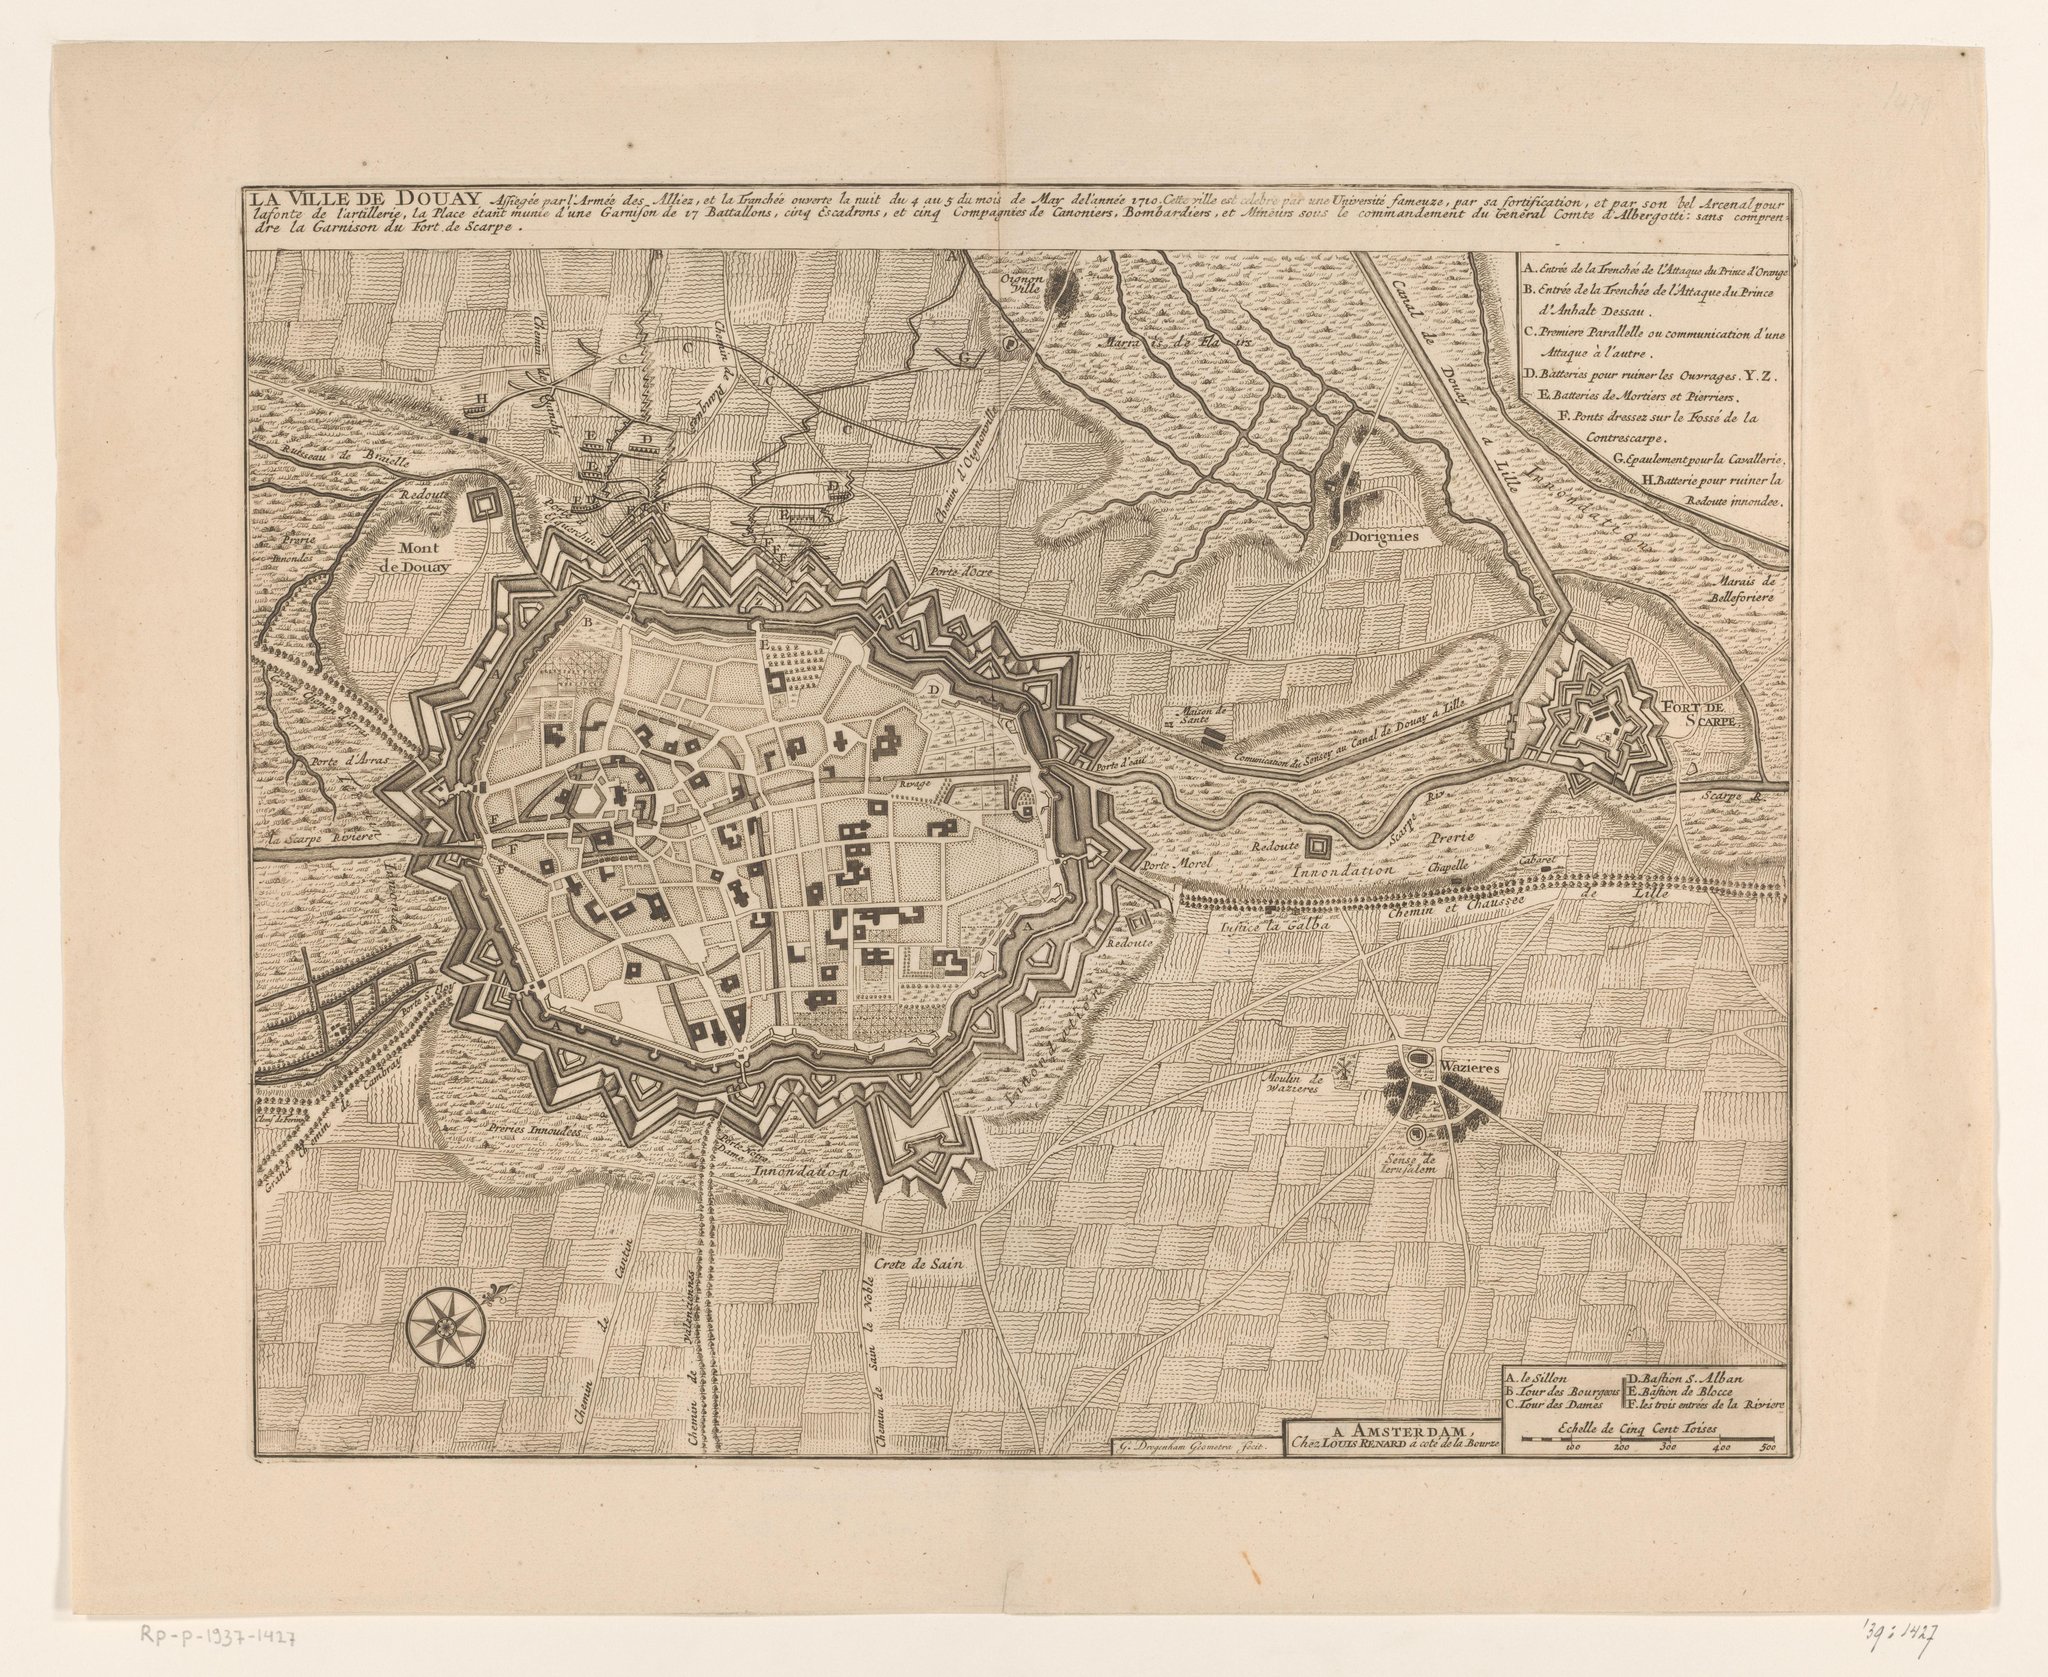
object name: print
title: Portret van Johan van Oldenbarnevelt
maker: jan frederik christiaan reckleben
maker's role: print maker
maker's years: 1819-1879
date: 1853-1855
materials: paper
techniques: engraving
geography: amsterdam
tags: the hague, johan van oldenbarnevelt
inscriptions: collector's mark: Lugt 2228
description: Illustratie in: Arend, Johannes Pieter. Algemeene geschiedenis des vaderlands van de vroegste tijden tot op heden. 5 delen, Amsterdam: Schleijer, J.F. 1840-1884, dl. 3.1, p. 188.